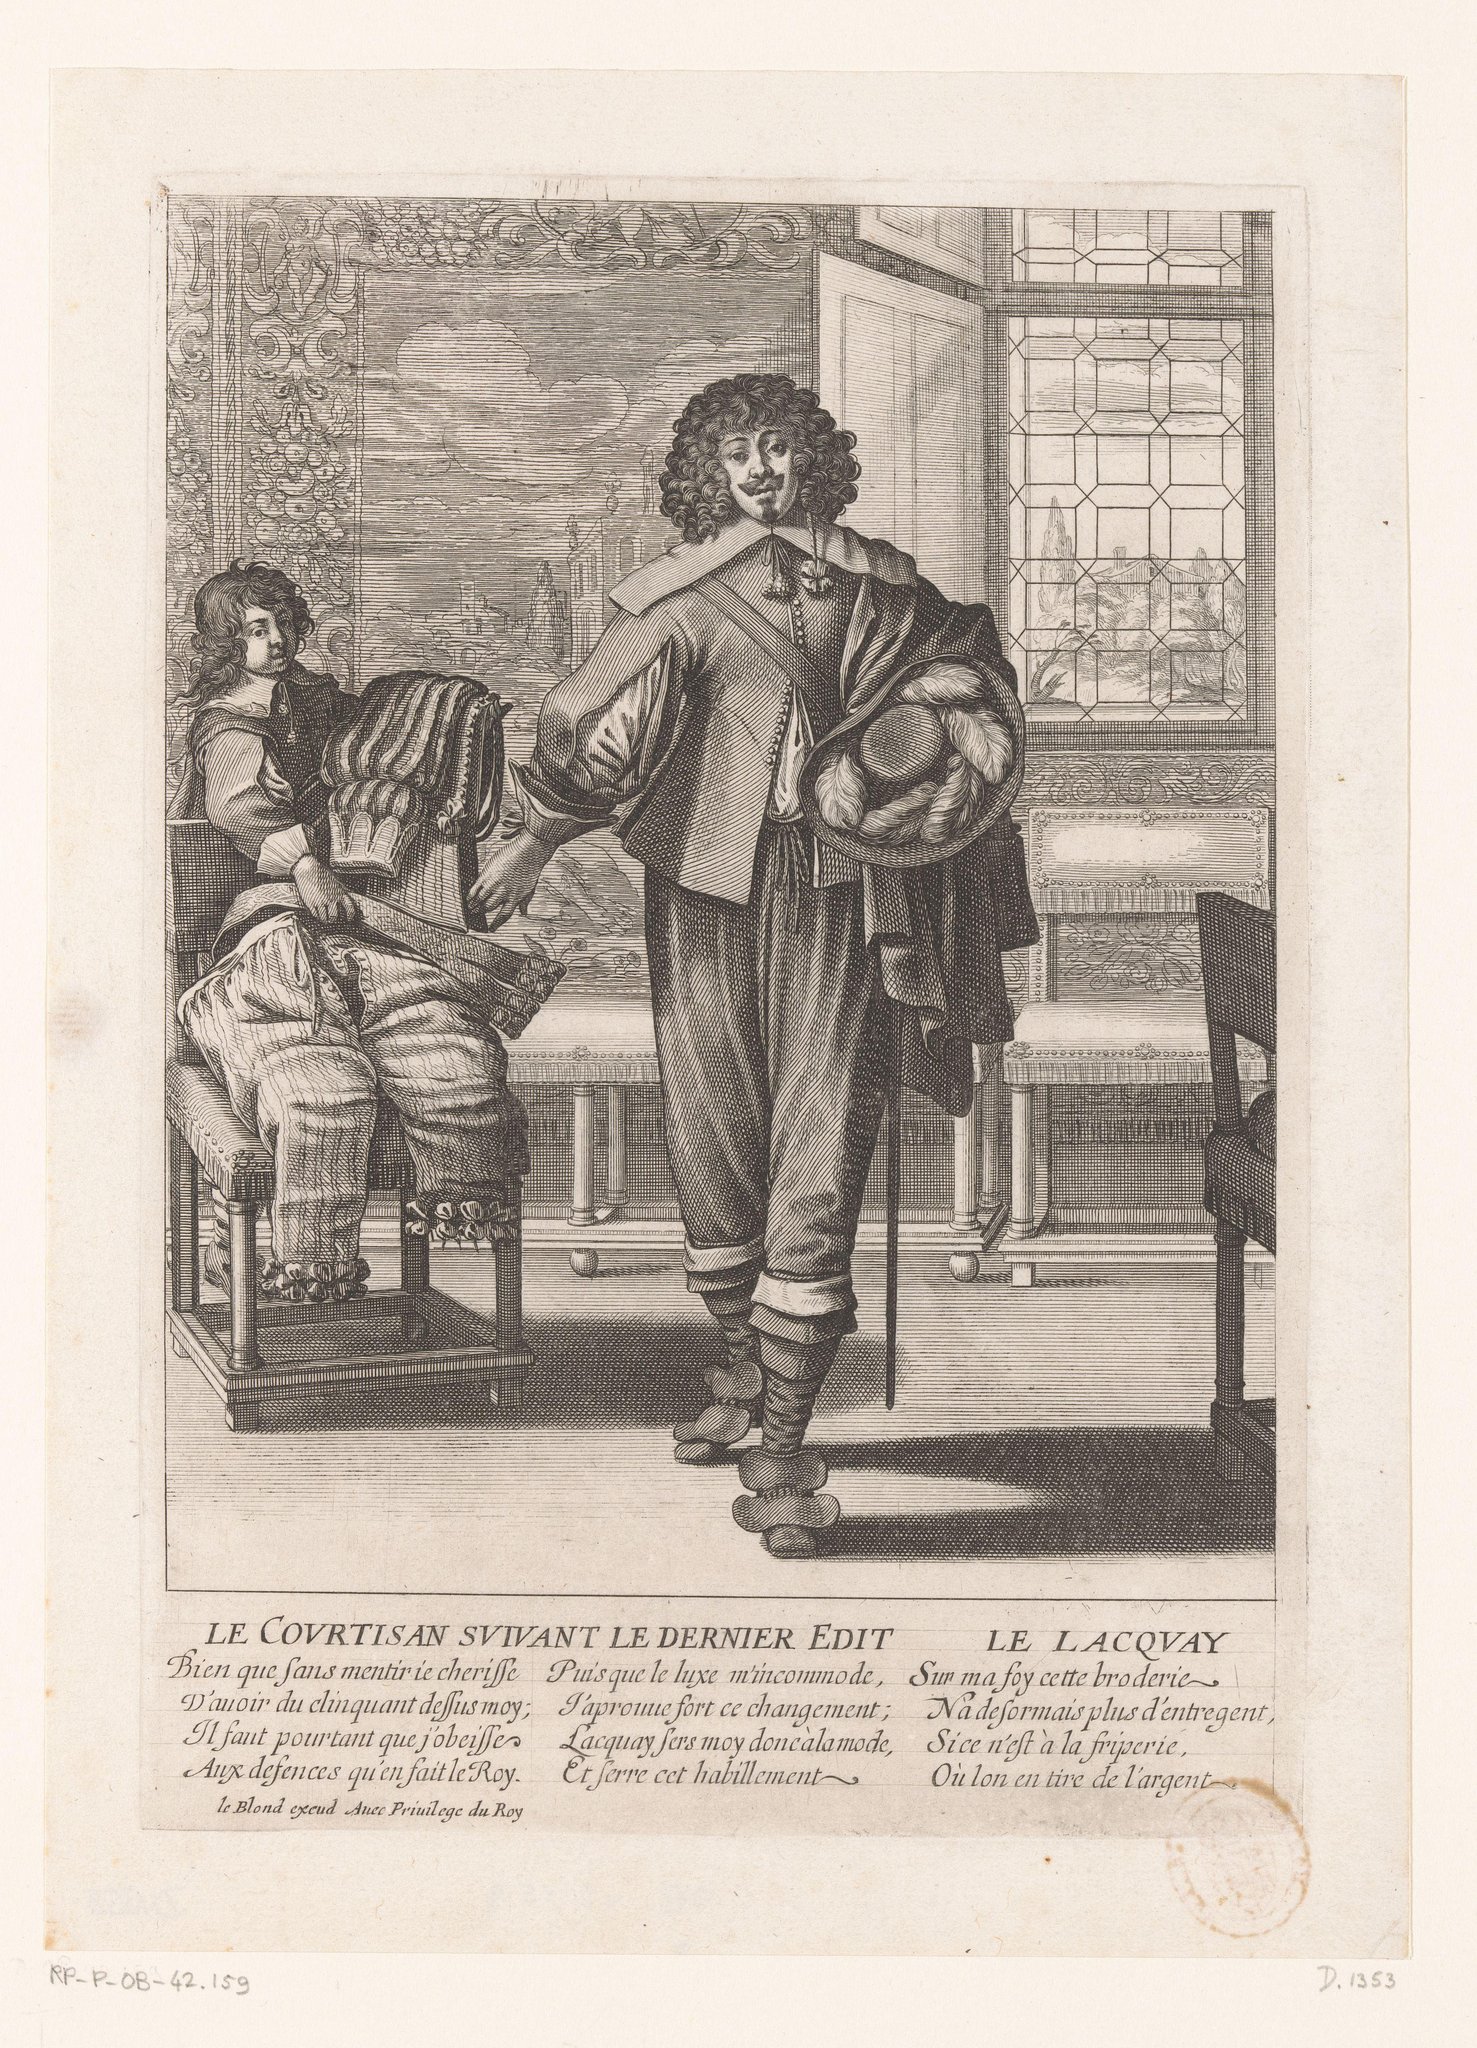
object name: costume print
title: Two Courtiers Following the Latest Edict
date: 1633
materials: paper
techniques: engraving, etching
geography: paris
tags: clothing for the upper part of the body (with name) (+ men's clothes), belt, girdle, waistband (+ men's clothes), shoulder-belt, bandoleer (+ men's clothes), border, ribbon, braid (+ men's clothes), coat (+ men's clothes), head-gear: hat (+ men's clothes), hacking and thrusting weapons: sword, servant, clothes, costume (+ men's clothes), communal rooms, neck-gear: collar (+ men's clothes), trousers, breeches, etc. (breeches) (+ men's clothes), clothing for the upper part of the body (doublet) (+ men's clothes), boots (+ men's clothes), closed window, head-gear: hat (+ feathers used for clothes)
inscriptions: collector's mark: Lugt 240, caption: ‘LE COURTISAN SUIVANT LE DERNIER EDIT: Bien que sans mentir je cherisse / D'avoir du clinquant dessus moy / Il faut pourtant que j'obeisse / Aux defences quen fait le Roy / Puis que le luxe m'incommode / l'aprouve fort ce changement / Lacquay sers moy donc à la mode / Et serre cet habillement. LE LACQUAY: Sur ma foy cette broderie / N'a desormais plus d'entregent / Si ce n'est à la friperie / Ou l'on en tire de l'argent.’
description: In 1633, Louis XIII outlawed clothing that was embellished with lace cutwork (reticella) or embroidered with silver and gold thread. The male courtier in the left print tells us that he is happy to adopt a more sober look. He lets his servant take the old garments to a secondhand shop. The female courtier, however, is very upset: she wants to enhance her natural beauty with fine clothing. Why should she be punished for that?